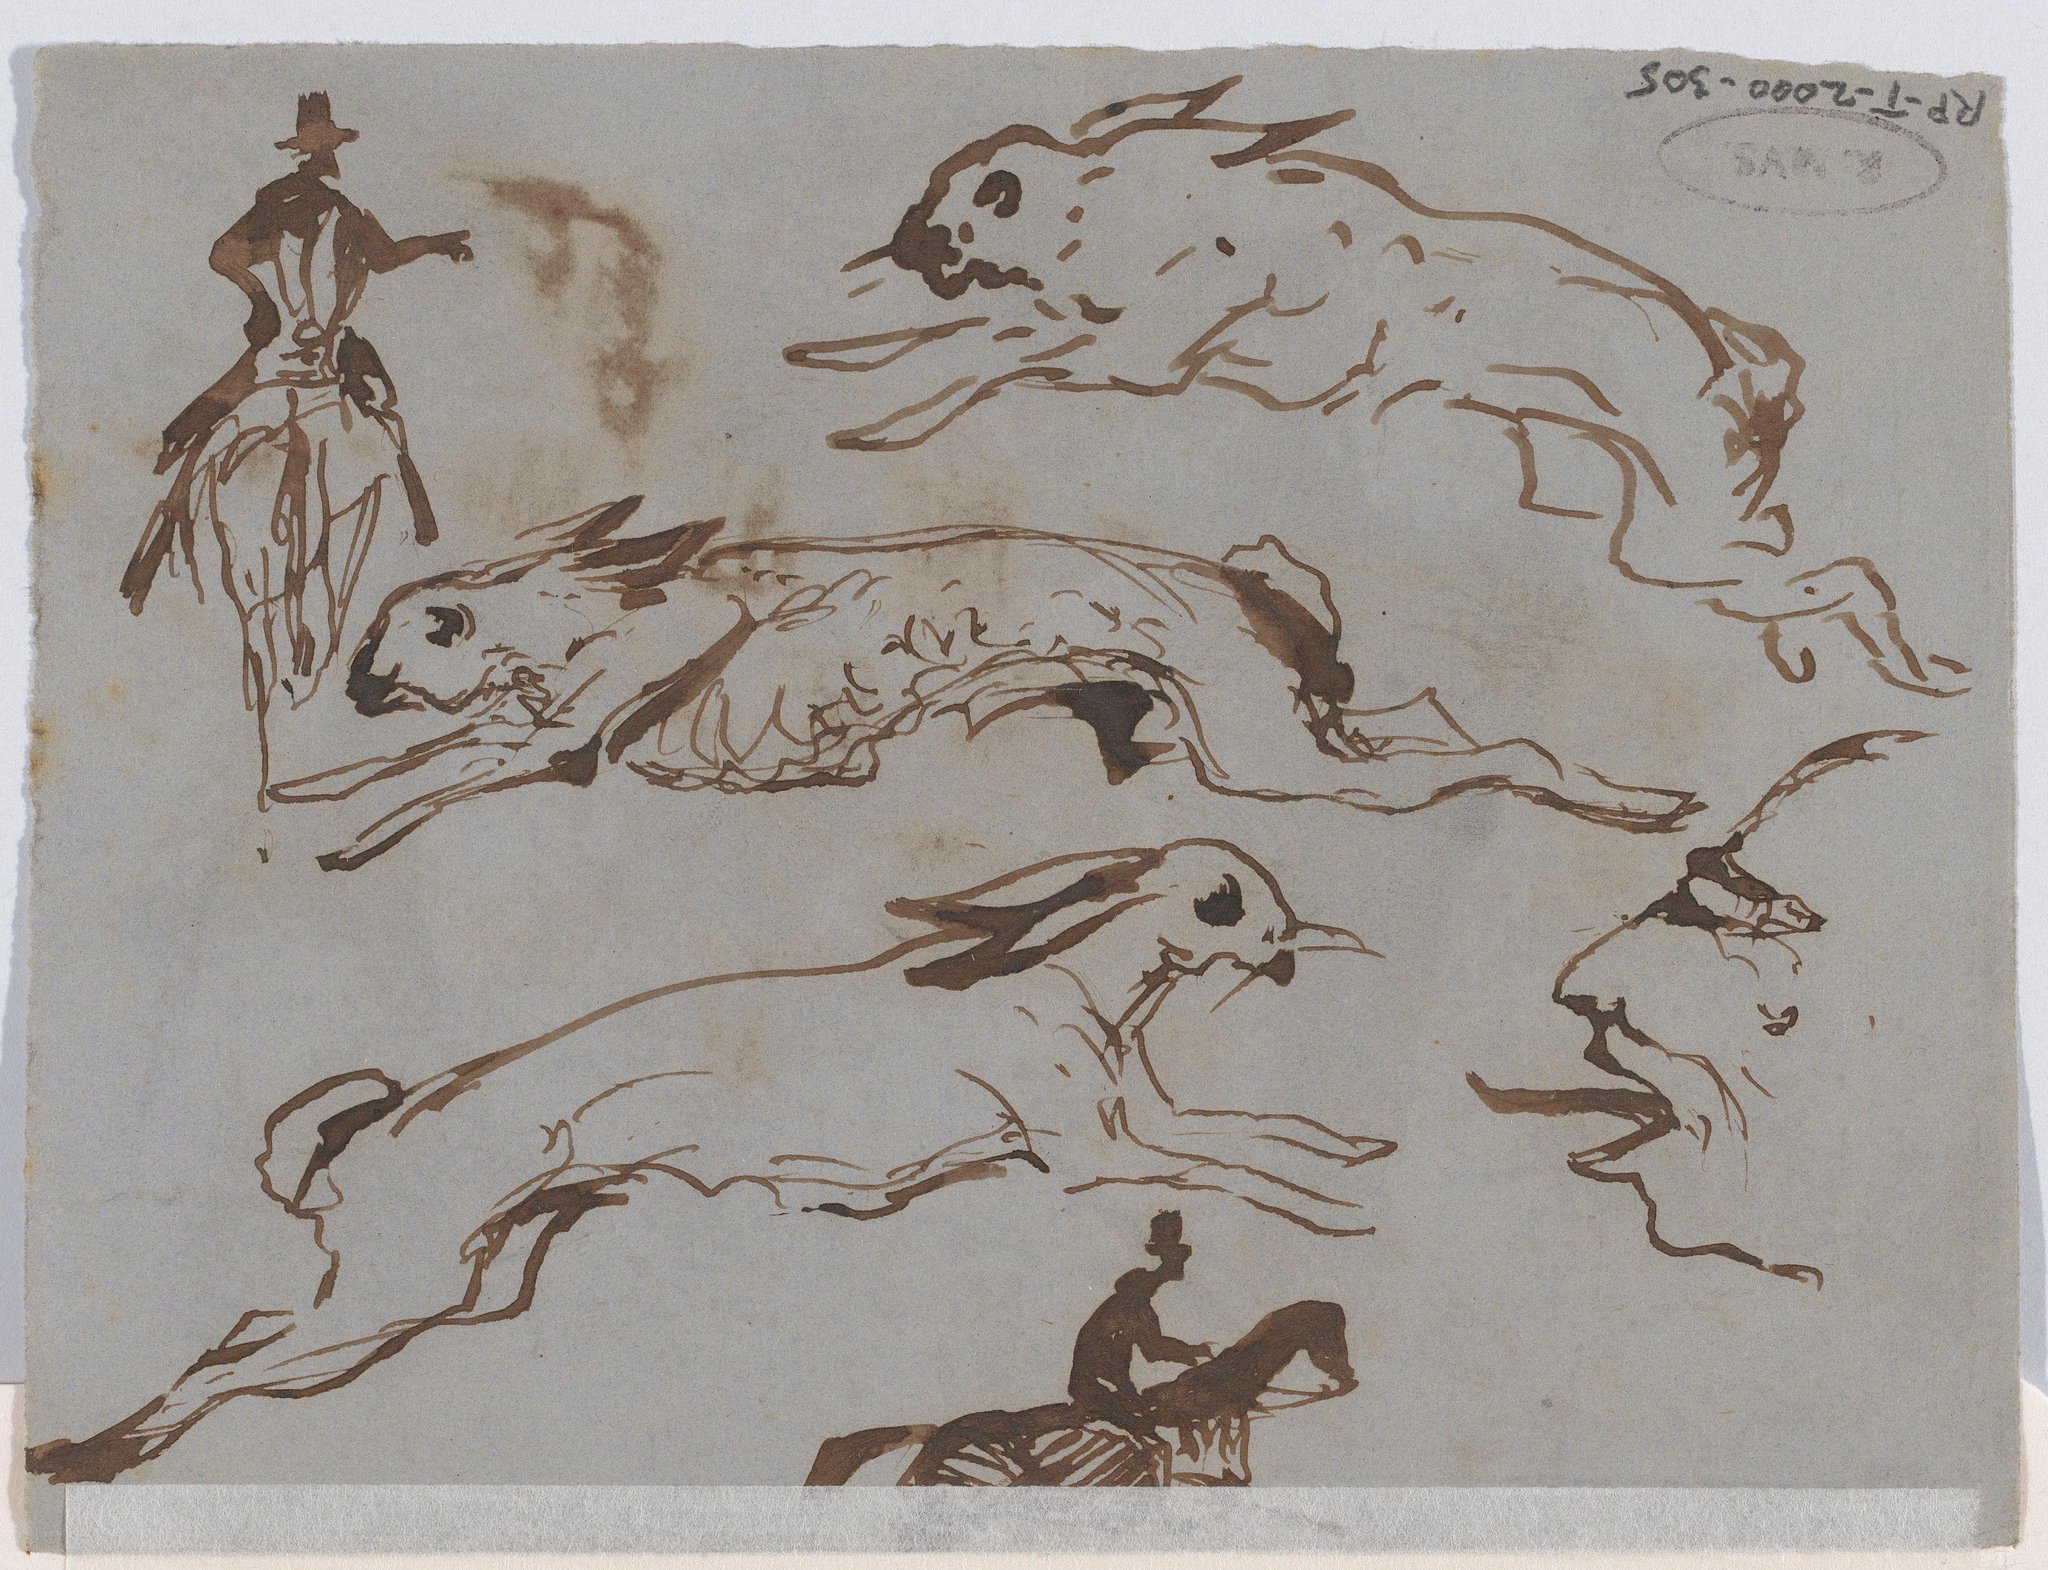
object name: drawing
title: Hazen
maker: johannes tavenraat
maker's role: draughtsman, painter, print maker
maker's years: 1809-1881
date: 1840-1880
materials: ink, paper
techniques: brush, pen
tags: riding a horse, ass, or mule; rider, horseman, caricatures (human types), rodents: hare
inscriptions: collector's mark: Lugt 2228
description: Schetsblad met hazen, ruiters en een kop met uitgestoken tong.